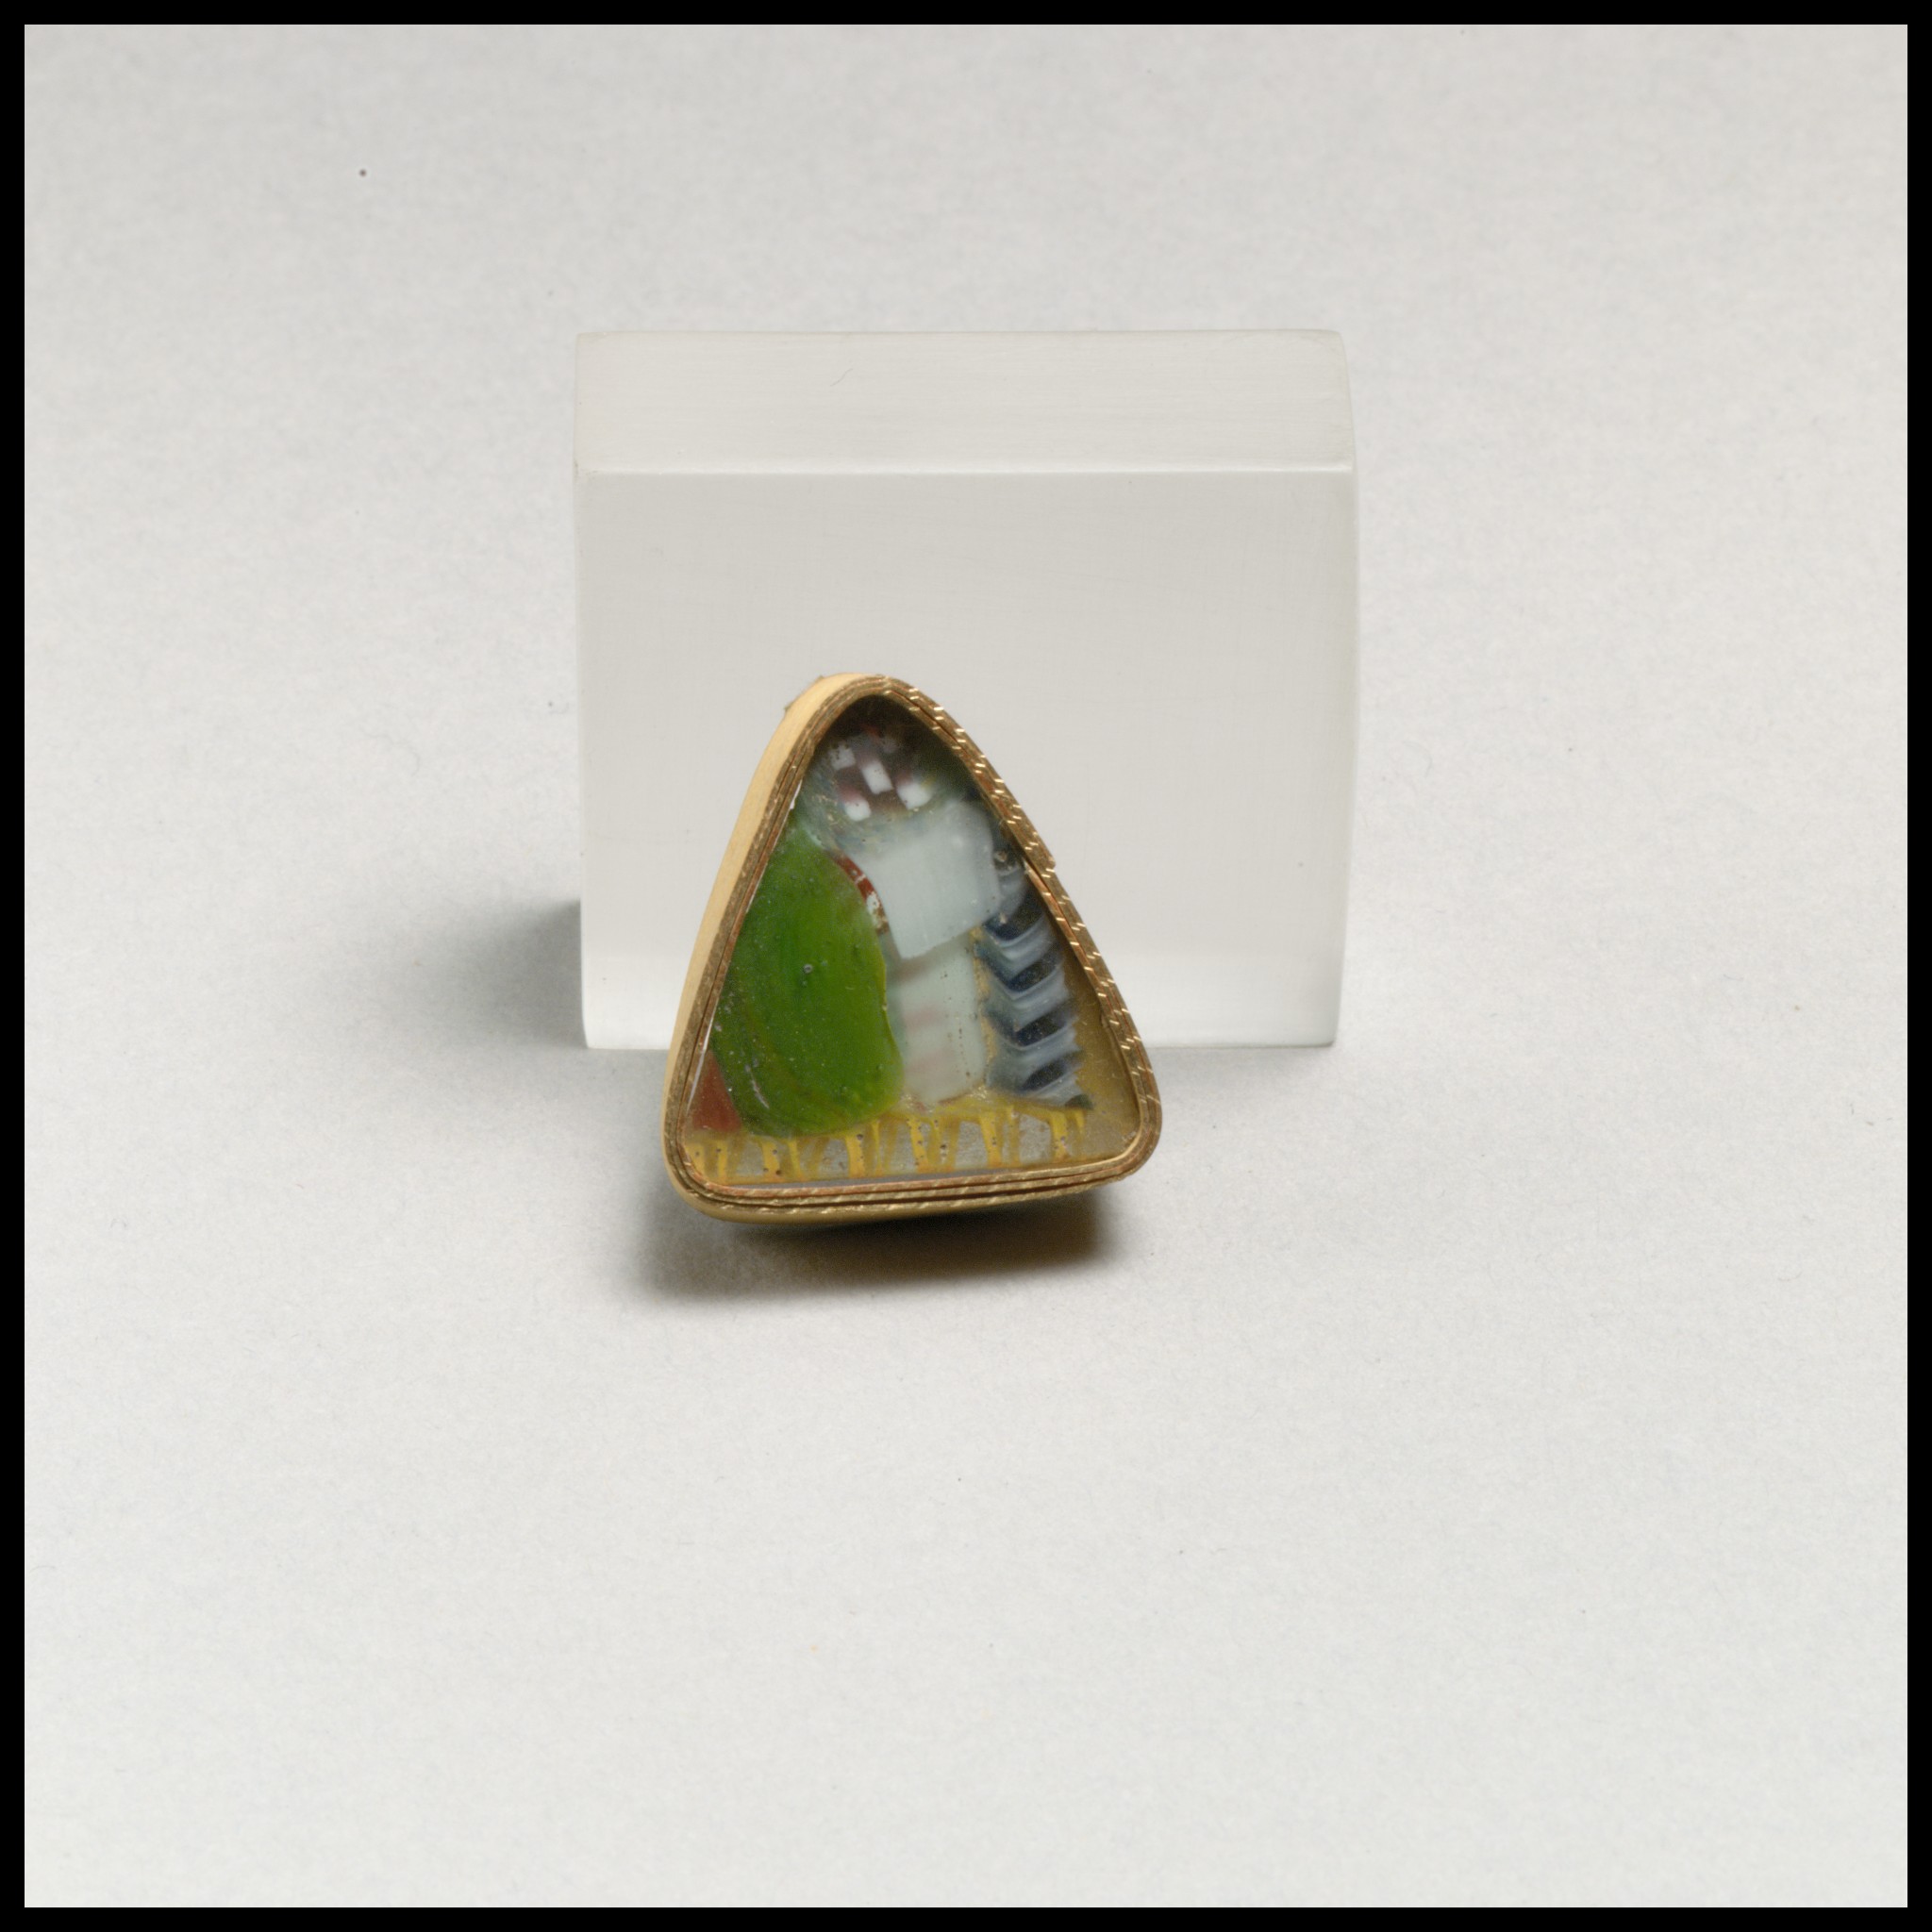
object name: fragment, mosaic bowl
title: Glass short-strip mosaic bowl fragment.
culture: roman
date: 34 BCE-33 CE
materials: glass